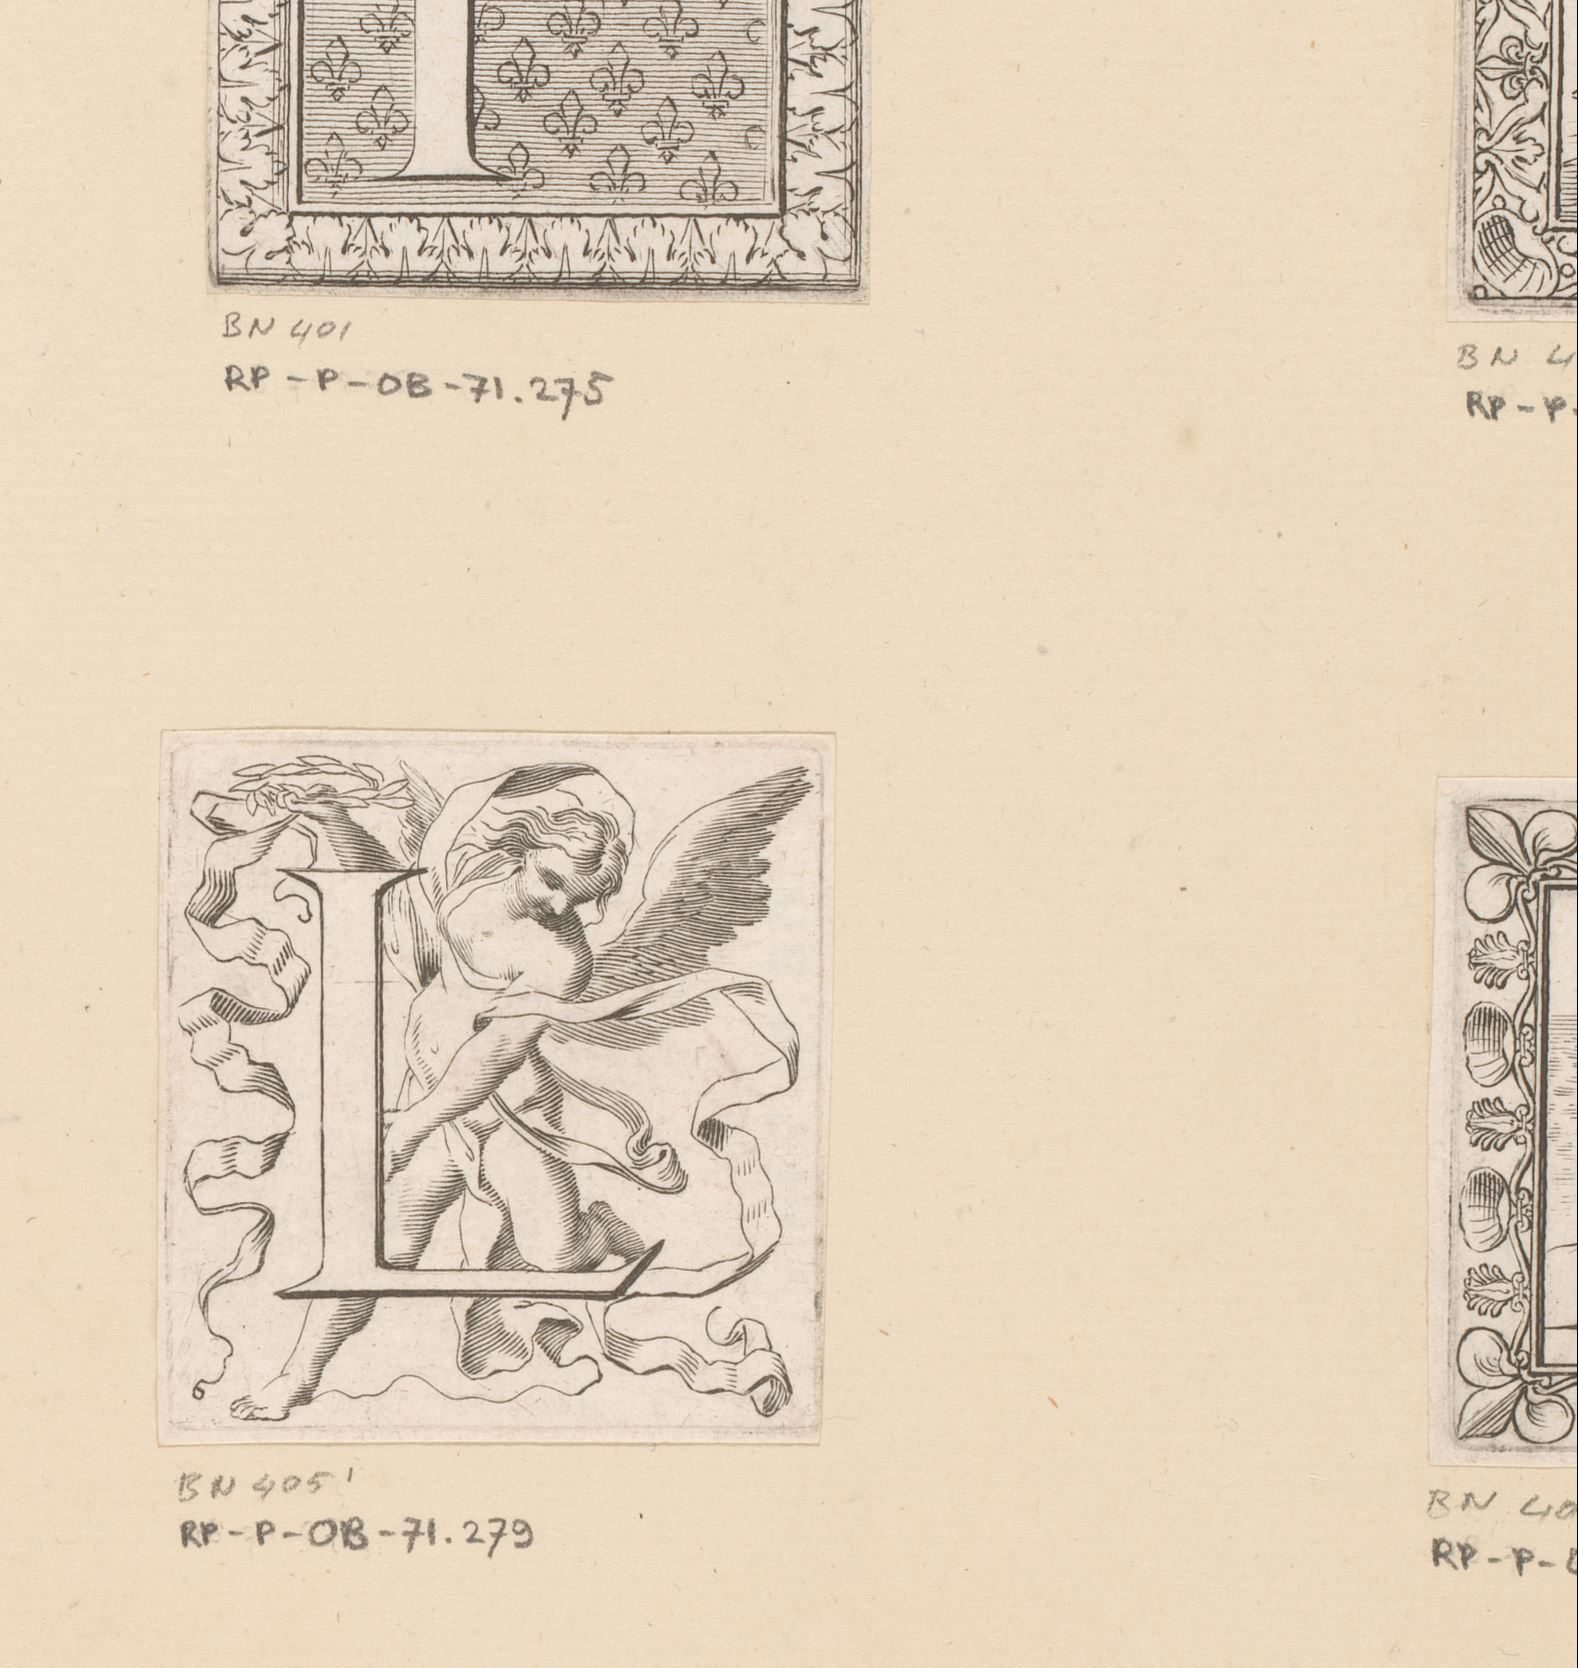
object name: print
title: Letter L met Victorie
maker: claude mellan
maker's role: draughtsman, print maker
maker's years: 1598-1688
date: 1639-1643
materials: paper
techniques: engraving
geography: paris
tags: decoration of printed matter, letters, alphabet, script, 'victoria'; 'vittoria', 'vittoria navale', 'vittoria degl'antichi' (ripa)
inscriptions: collector's mark: Lugt 240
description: Dit betreft één van de 21 letters die Mellan voor de Imprimerie Royale vervaardigde. Elke letter wordt vergezeld door een afbeelding van een onderwerp dat met dezelfde letter begint. Tussen 1639-1643 werkte Mellan samen met de Imprimerie Royale (IFF 17e siècle, p. 21-22). Hij vervaardigde verschillende vignetten, letters, culs-de-lampe en decoratieve banden (IFF 17e siècle, p. 215-220). Prent gebruikt voor: Biblia Sacra. Parijs: Imprimerie Royale, 1642. ZIe IFF 17e siècle, p. 219, nr. 405.